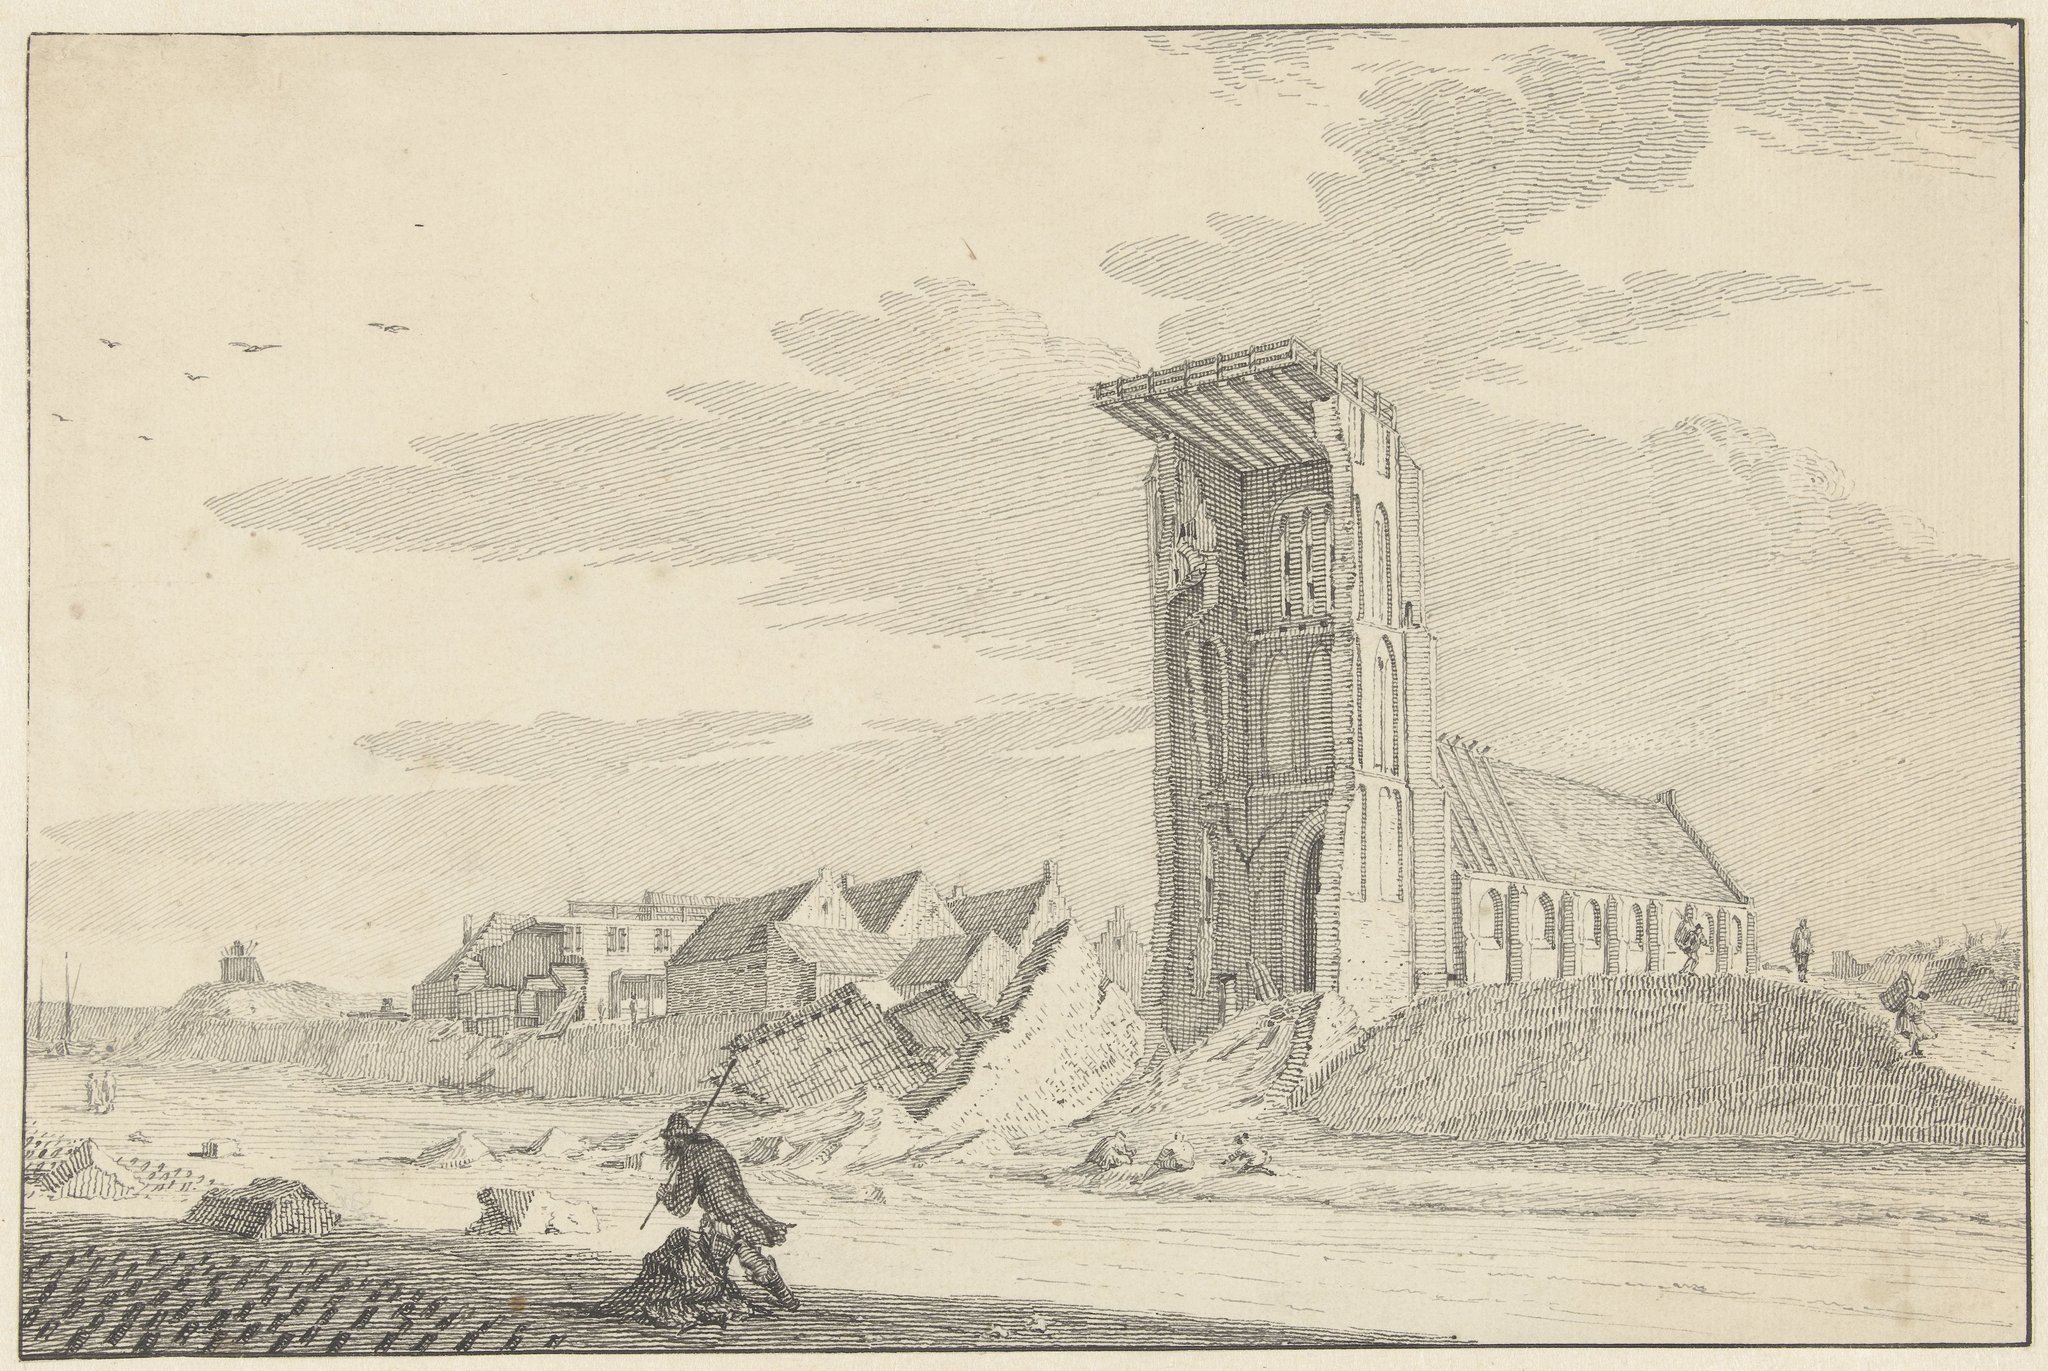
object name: drawing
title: De ruïne van de toren van de kerk te Egmond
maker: hendrik spilman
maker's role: draughtsman, painter, print maker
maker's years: 1721-1784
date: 1741-1743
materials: ink, paper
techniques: pen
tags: ruin of church, monastery, etc., historical events and situations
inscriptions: inscription: ‘H. Spilman f Ruinen van de Toren van Egmond met de neergeslage muur / in't jaar 1741 door sware storm nu niet meer in wesen / kort daar na getekent na het leven door H Spilman’